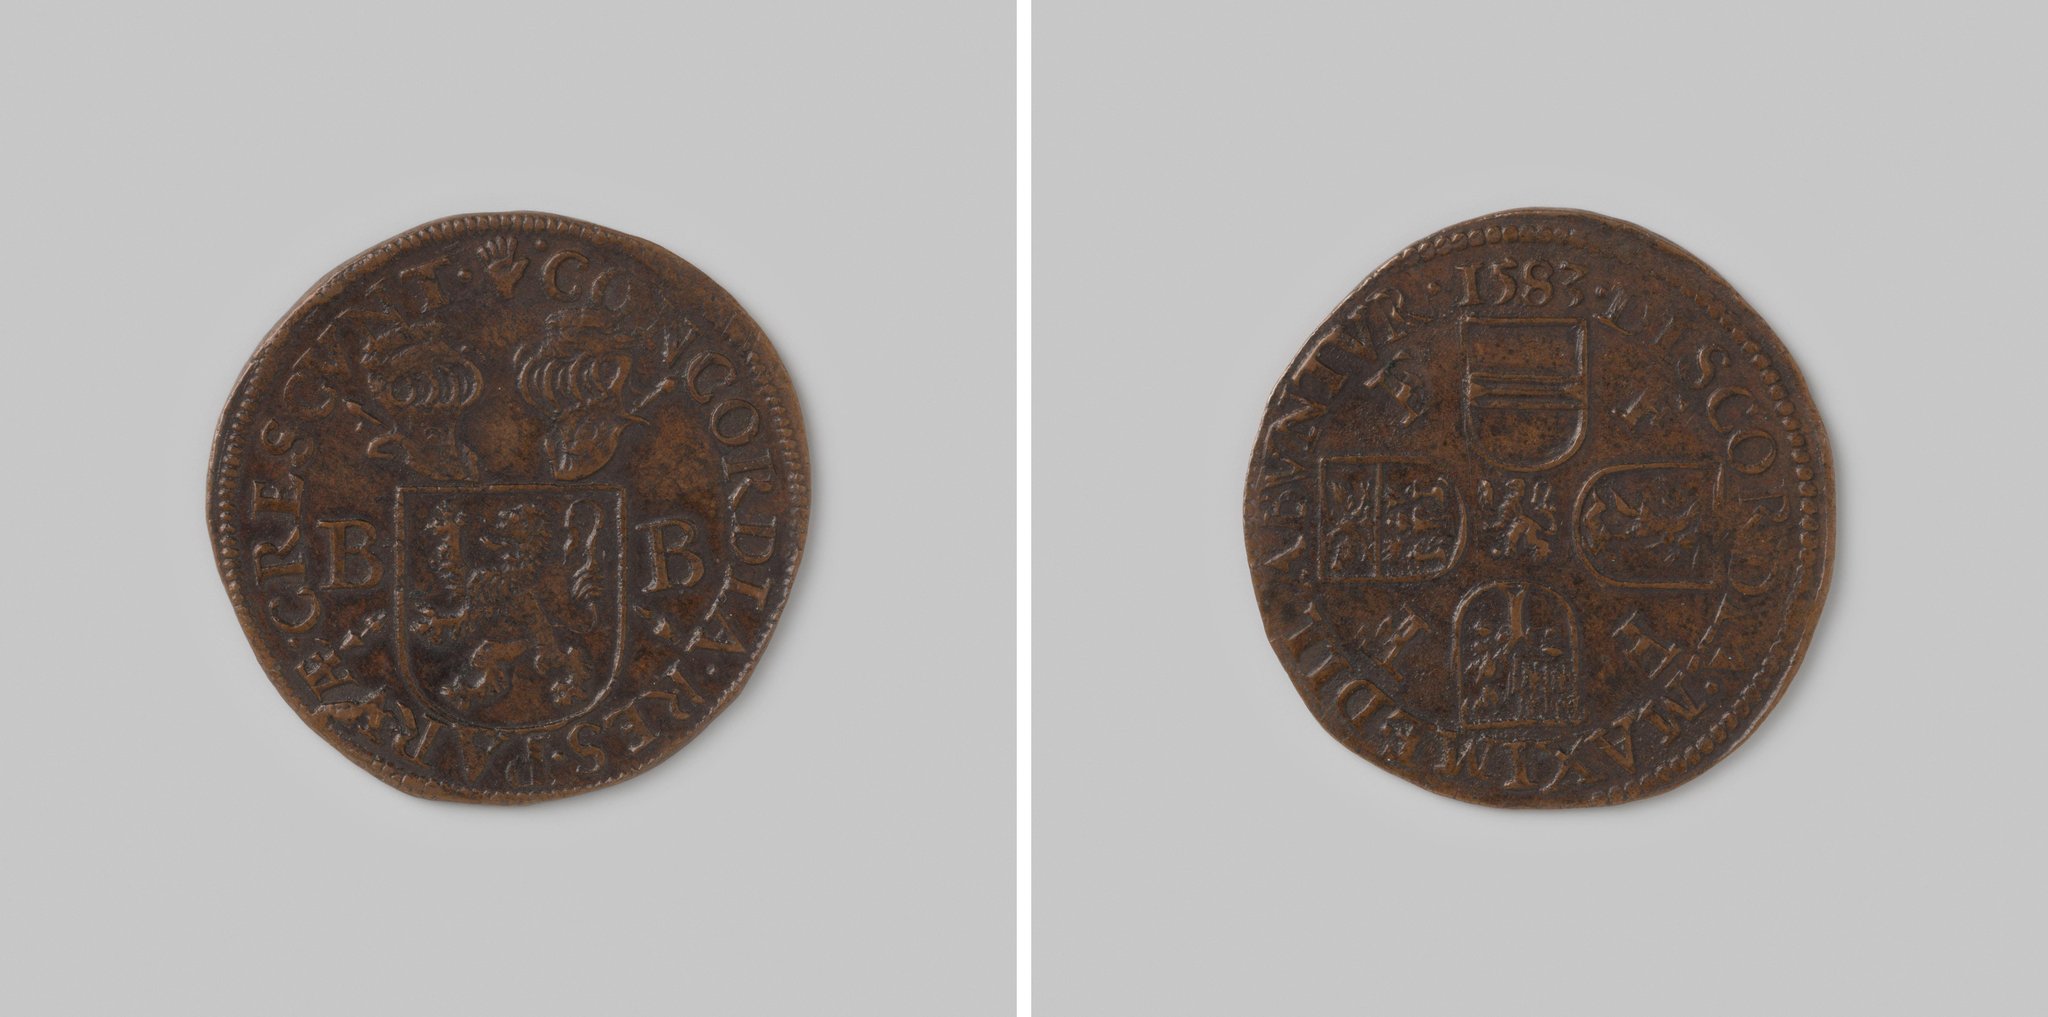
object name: history medal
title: Rekenpenning uit Antwerpen op de haat tegen Spanje 1583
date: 1583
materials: copper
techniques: striking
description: Koperen penning, op de voorzijde een wapenschild op twee gekruiste speren gedekt door twee helmen en geflankeerd door twee letters B, met omschrift, op de keerzijde vier radiaal geplaatste wapenschilden waartussen letters F rond een klimmend leeuwtje, met omschrift.